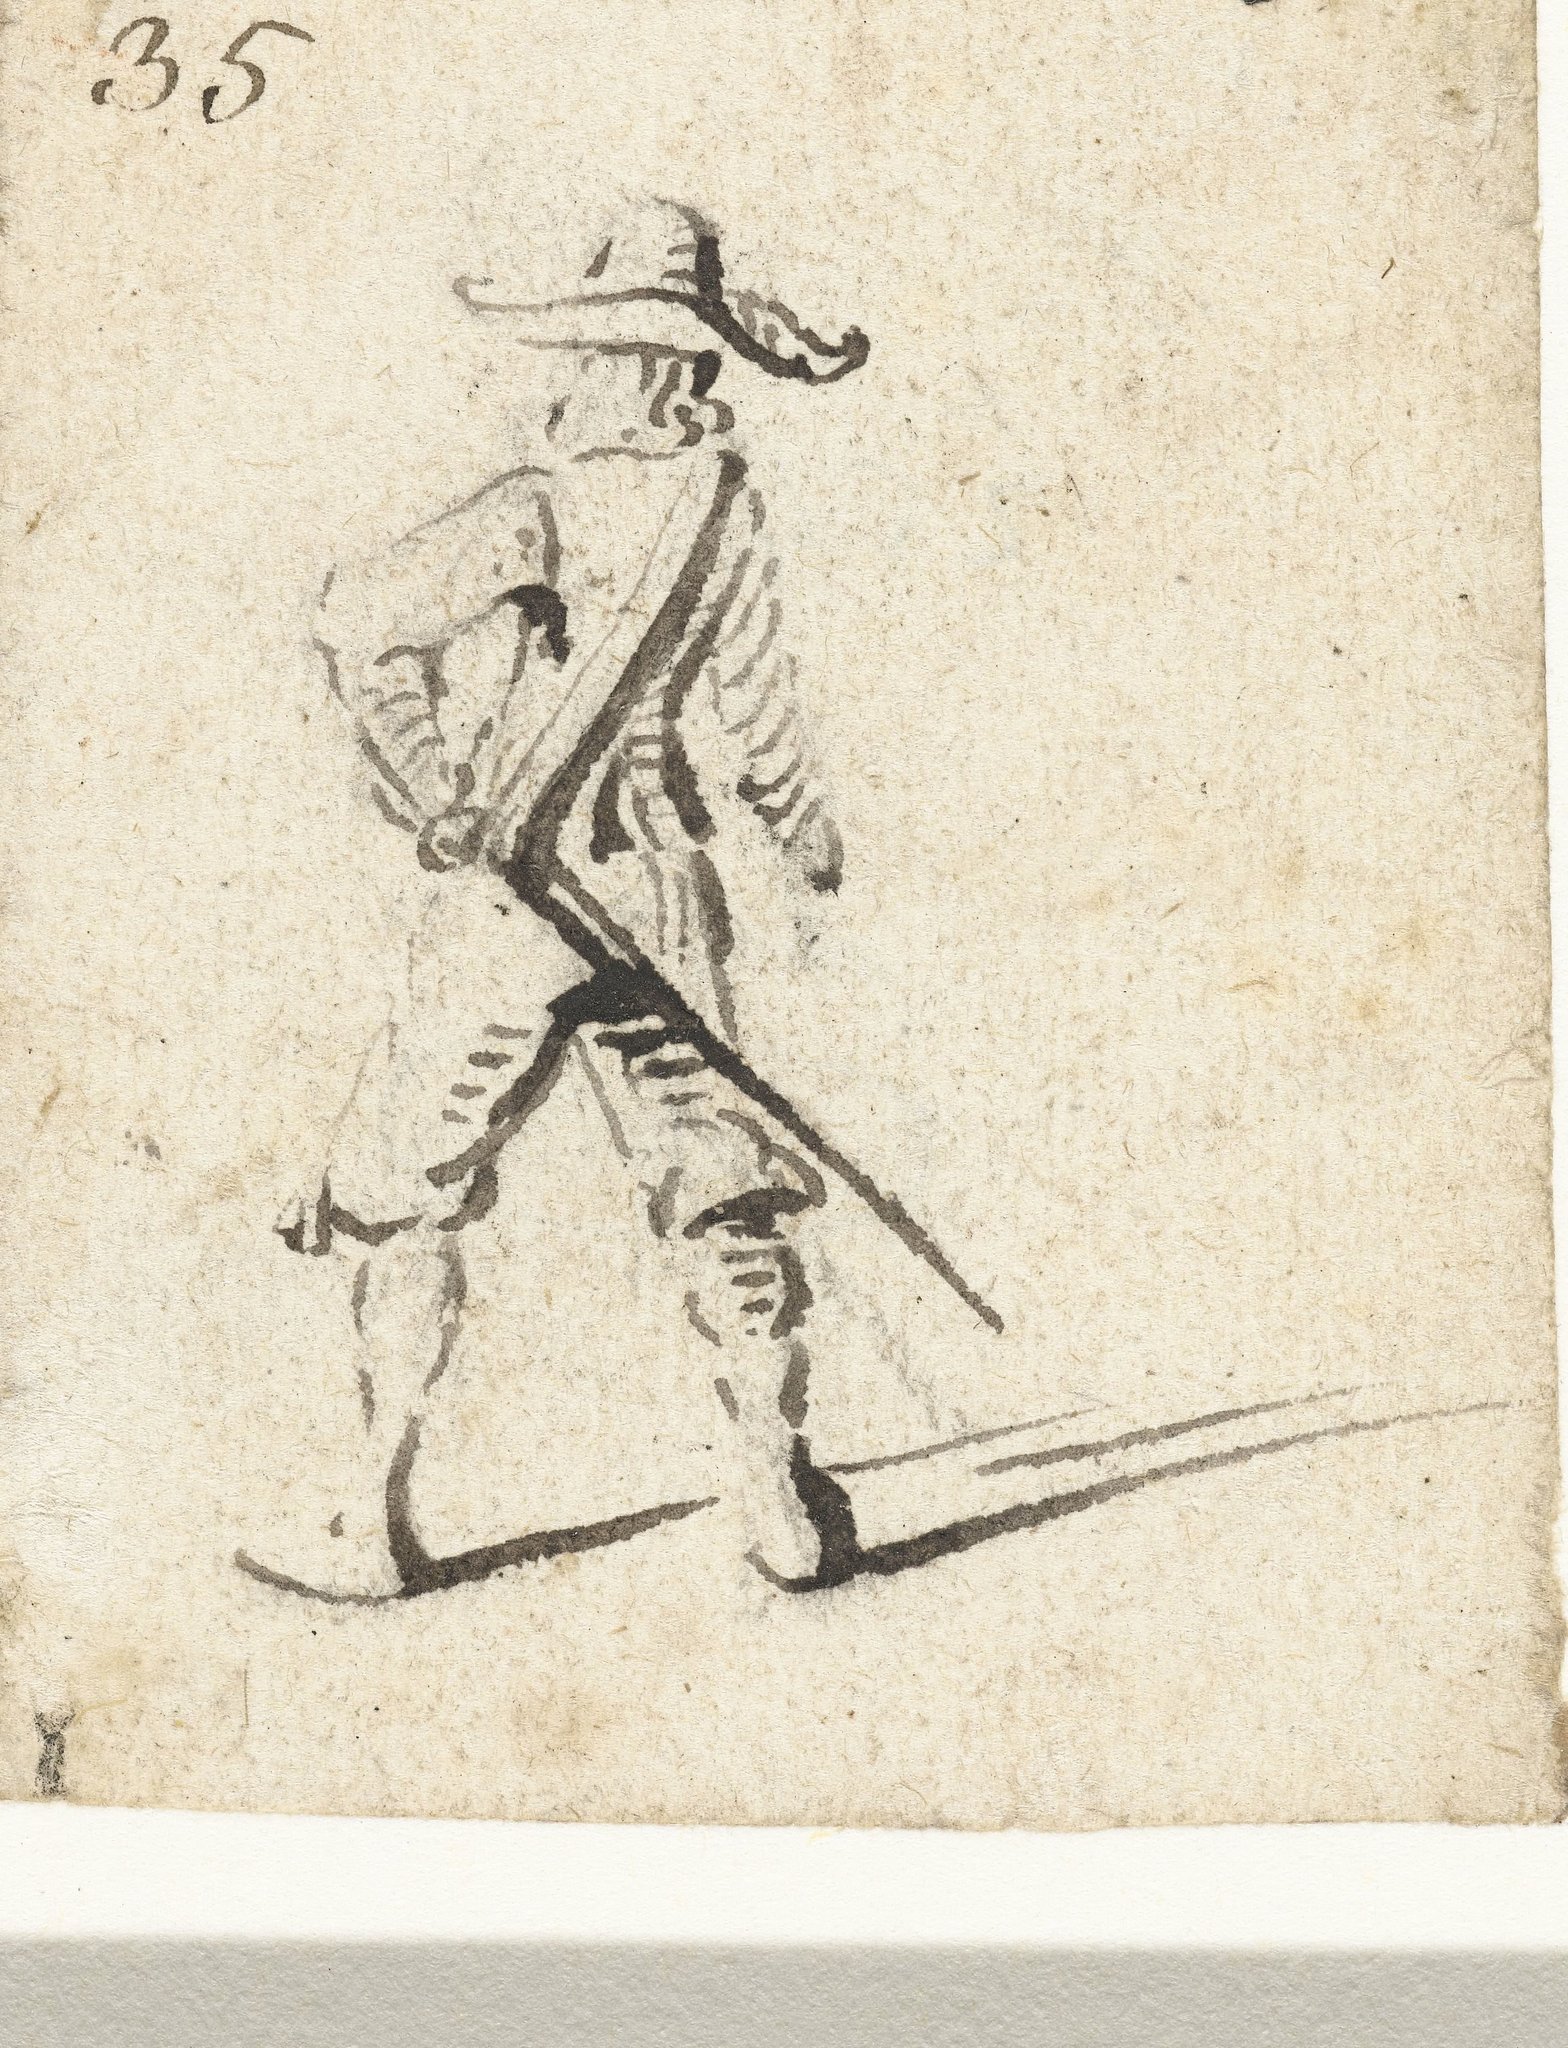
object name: drawing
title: Soldaat, van achteren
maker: harmen ter borch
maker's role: draughtsman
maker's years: 1638-1677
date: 1649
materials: chalk, ink, paper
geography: zwolle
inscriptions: annotation: ‘H.t.B.inventor 1649’